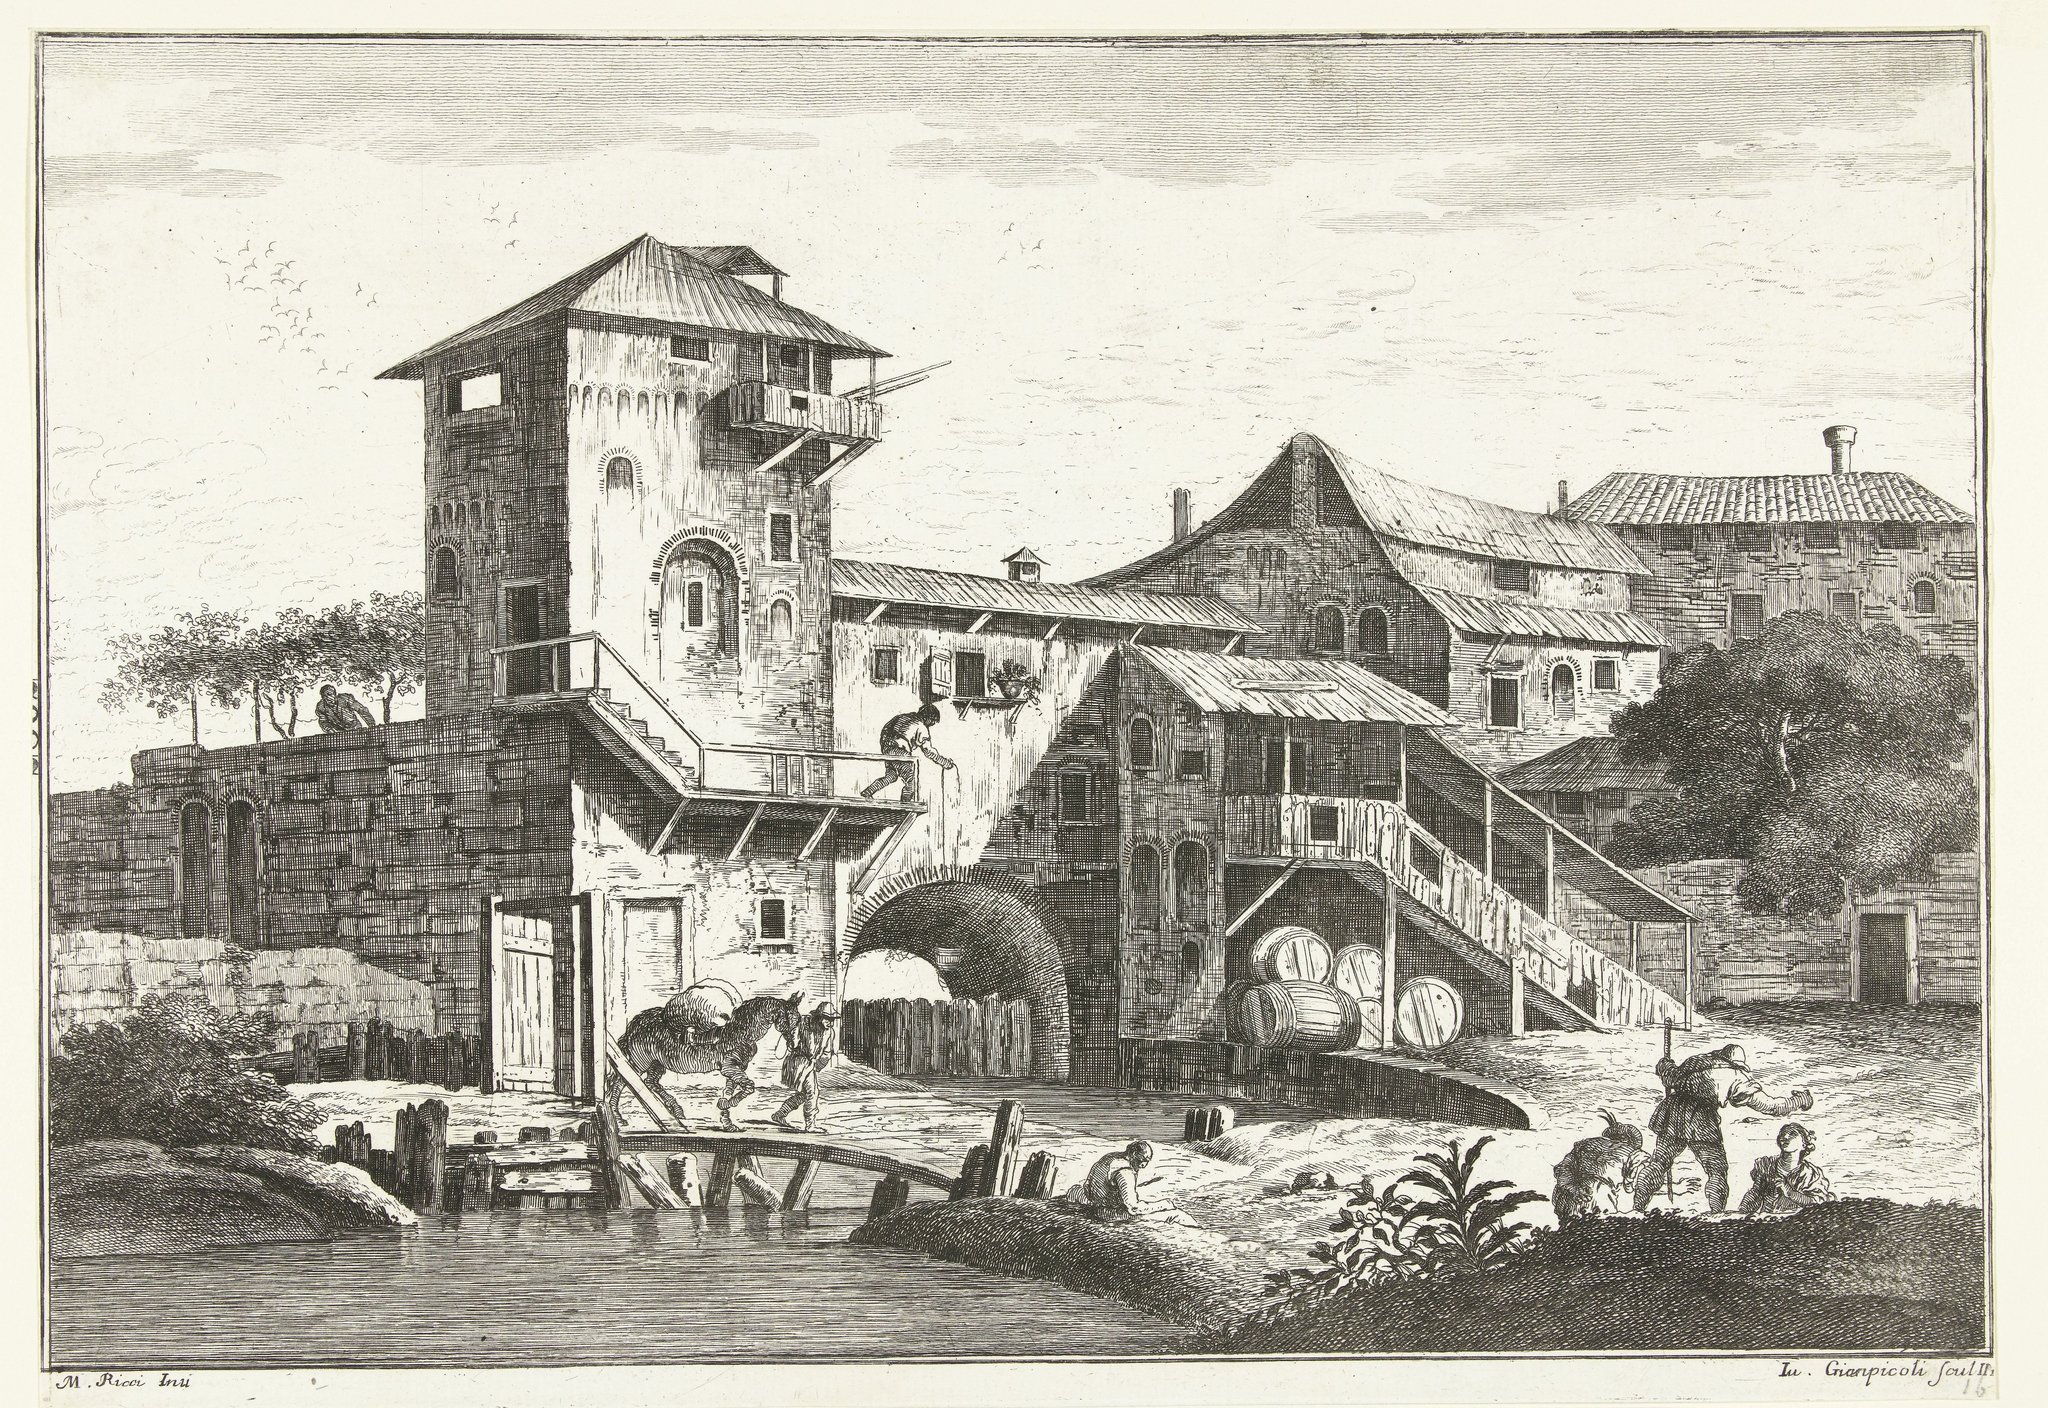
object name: print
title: Italiaanse landschappen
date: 1739-1740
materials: paper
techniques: etching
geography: venice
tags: landscape with tower or castle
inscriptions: collector's mark: Lugt 2228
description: Prent uit tweede serie van negentien prenten met achttien Italiaanse landschappen naar ontwerp van Marco Ricci en titelprent (zie RP-P-1952-1). Tweede serie is opgedragen aan Antonio Maria Zanetti. De serie in de collectie van het RMA is gedrukt in de eerste staat voor vermelding van de uitgever Teodoro Viero. Het serienummer 16 is van het blad afgesneden.